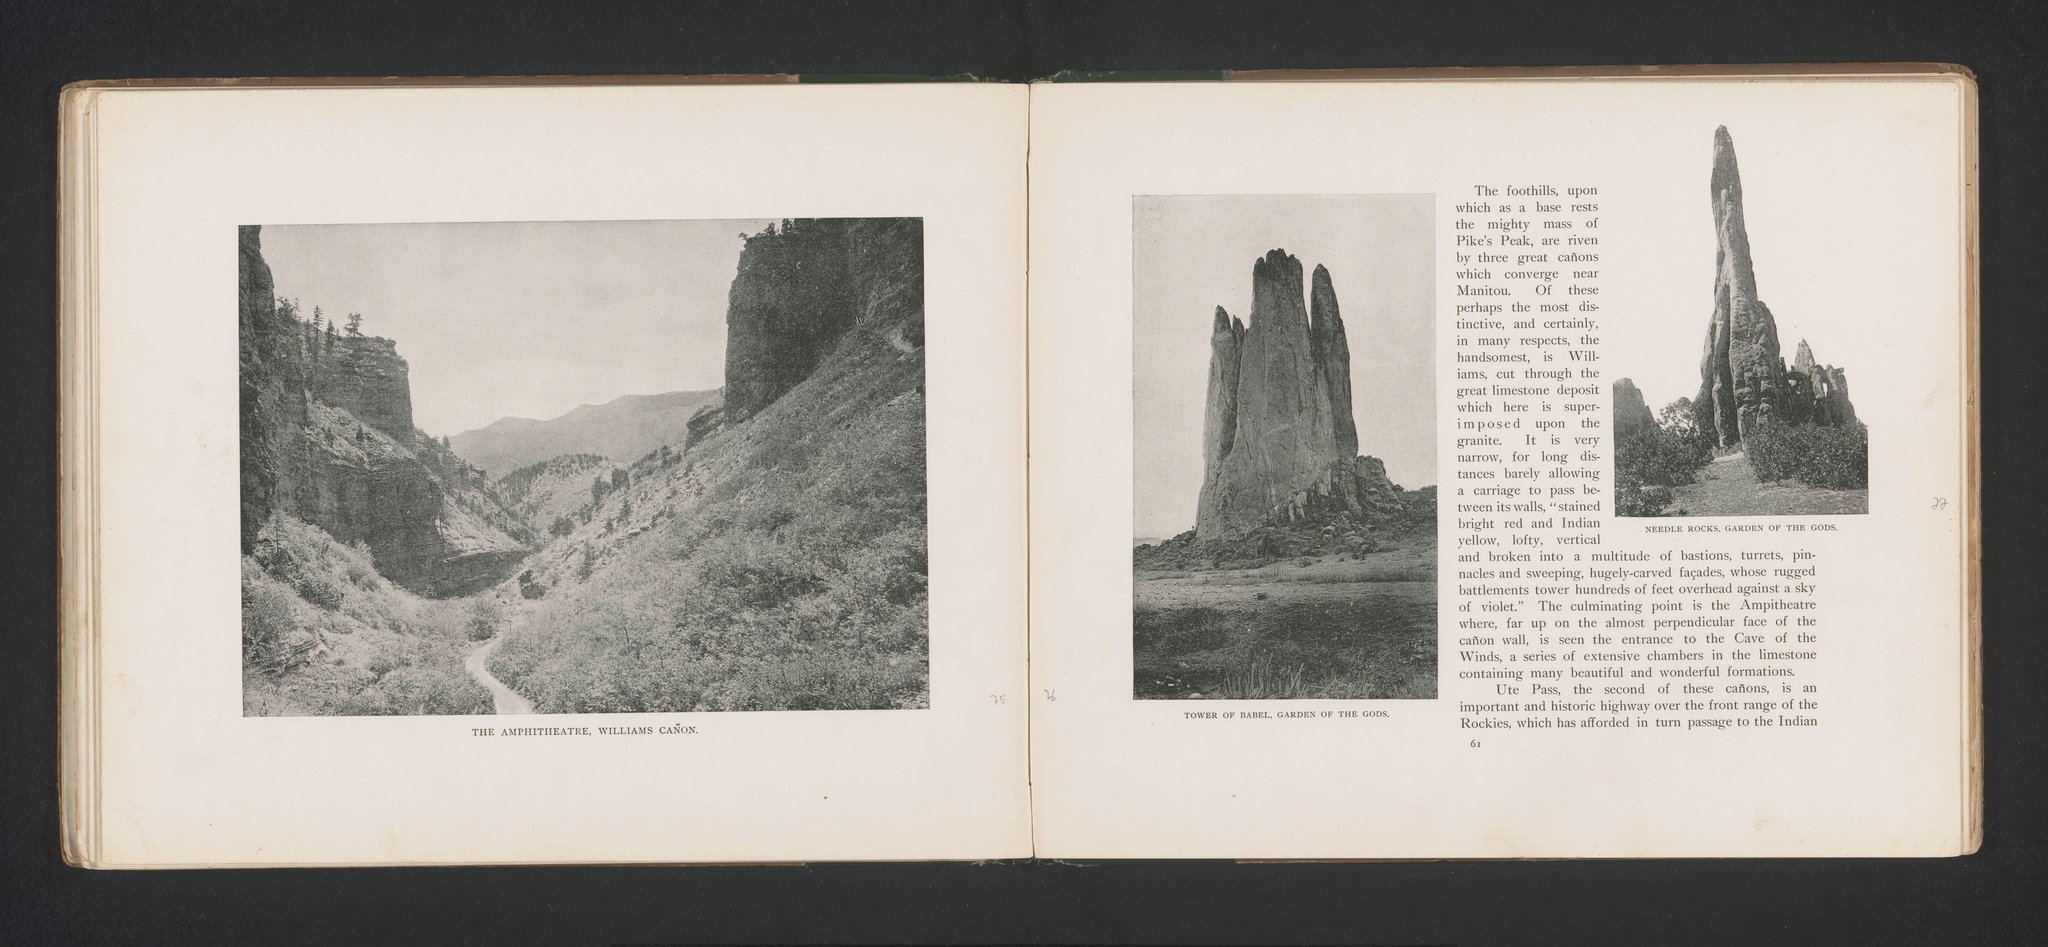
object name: page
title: Gezicht op de Williams Canyon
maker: Anonymous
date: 1888-1893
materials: paper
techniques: autotype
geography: williams canyon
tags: landscapes, ravine, chasm, abyss, canyon